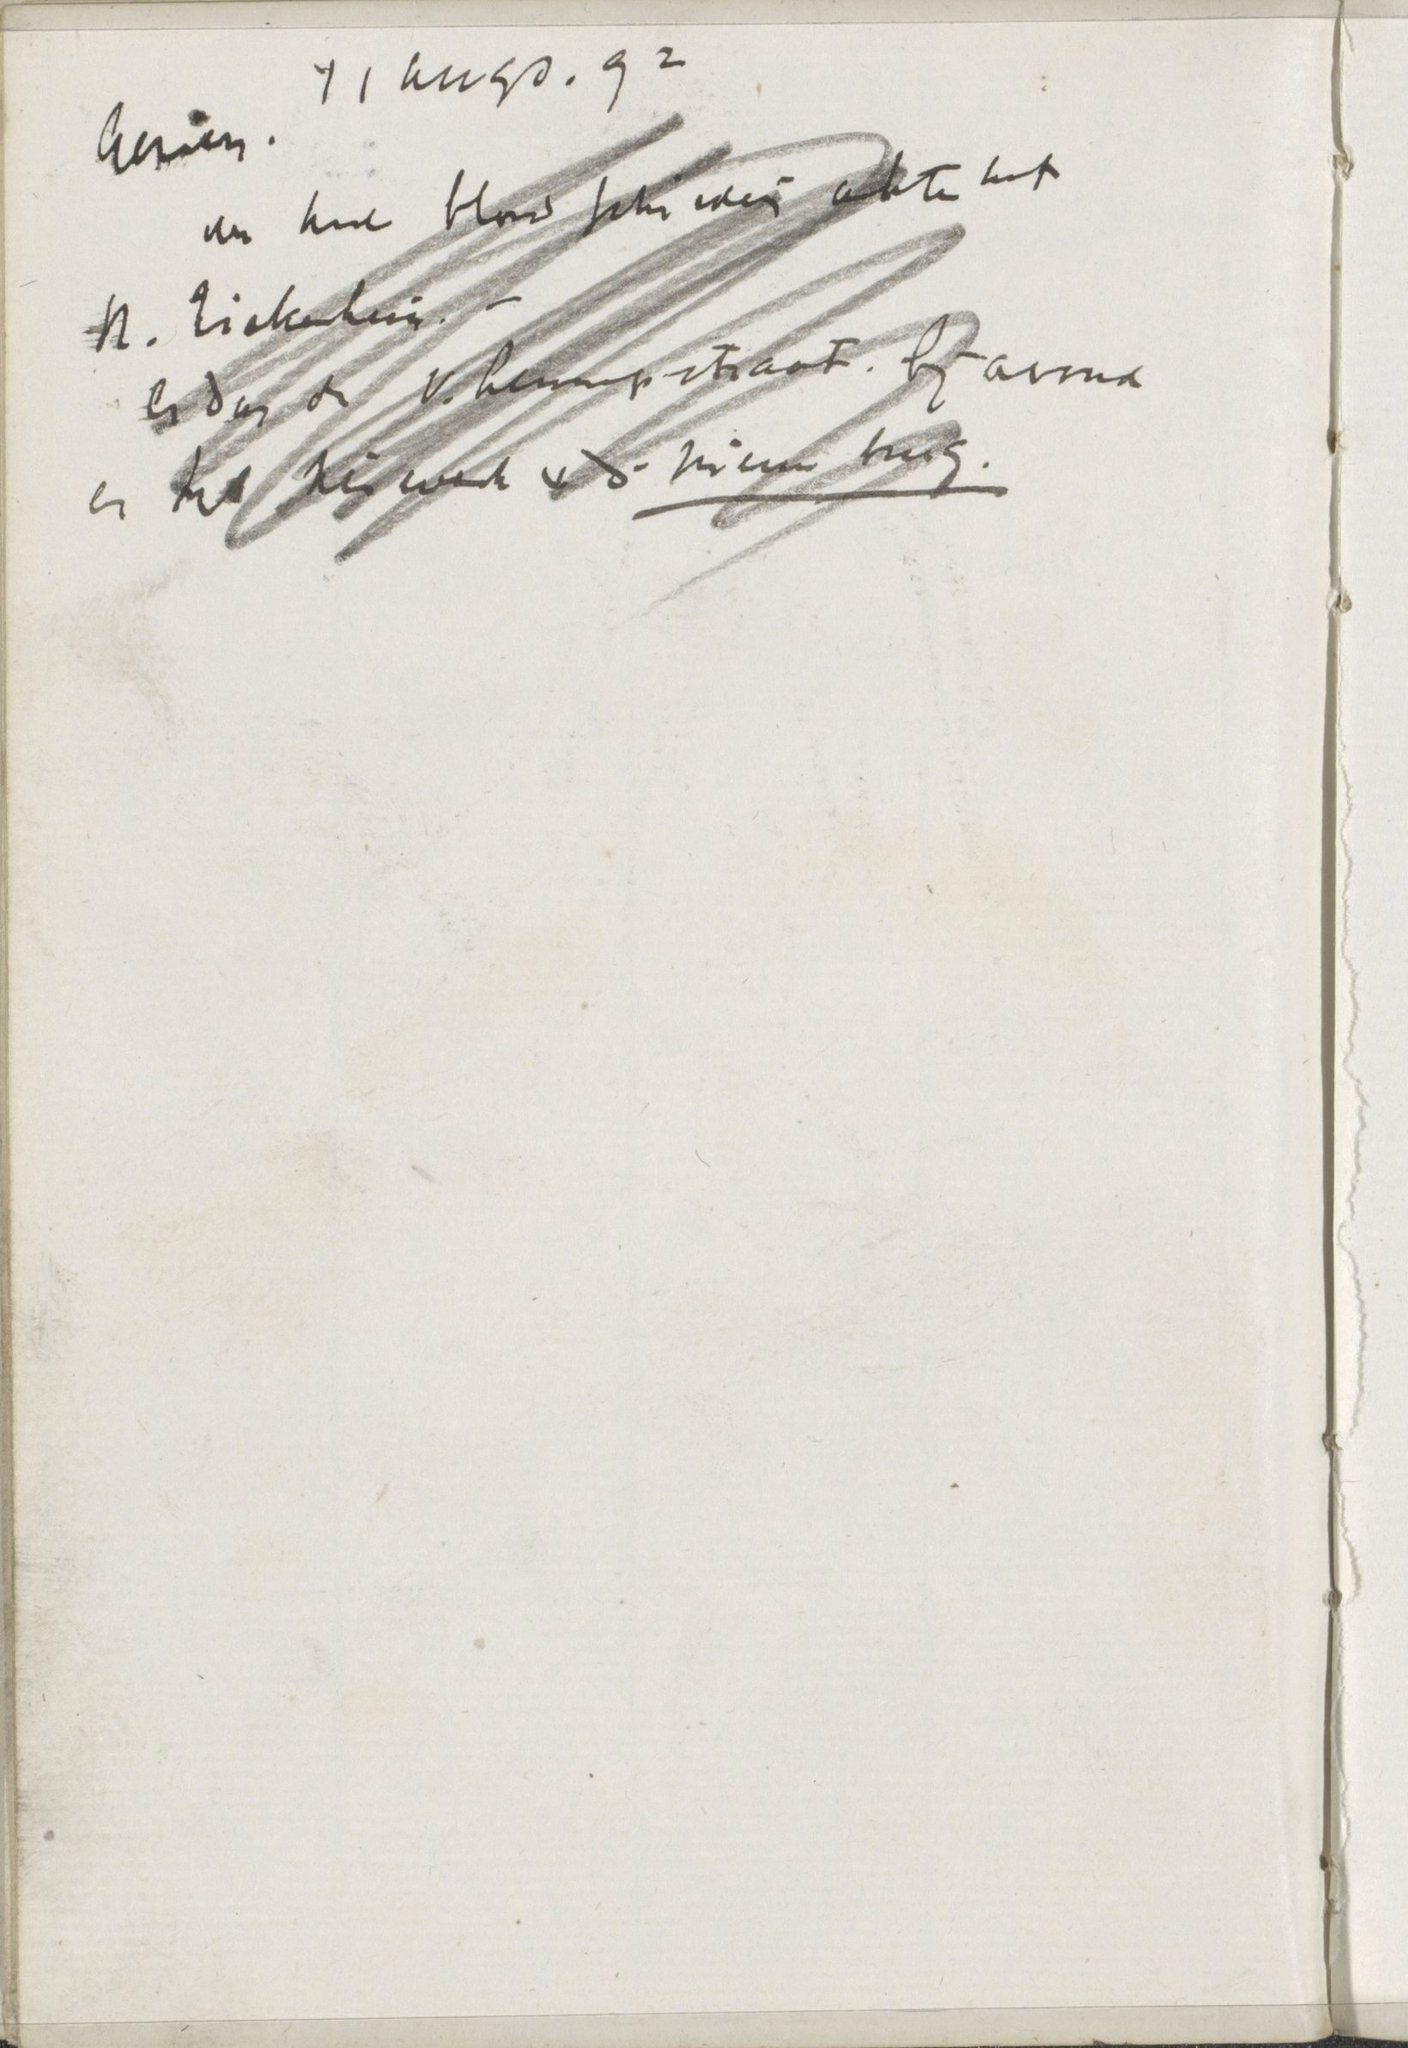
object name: sketchbook leaf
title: Annotaties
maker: george hendrik breitner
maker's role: draughtsman, painter, print maker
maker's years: 1857-1923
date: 1892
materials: chalk, paper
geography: amsterdam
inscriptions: annotation: ‘11 Augs. 92/ Gezien./ [...]/ N. Ziekenhuis/ en dan de v. Lennepstraat bij avond/ en het heiwerk v.d. nieuwe brug’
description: Pagina 7 uit een schetsboek met 20 bladen.